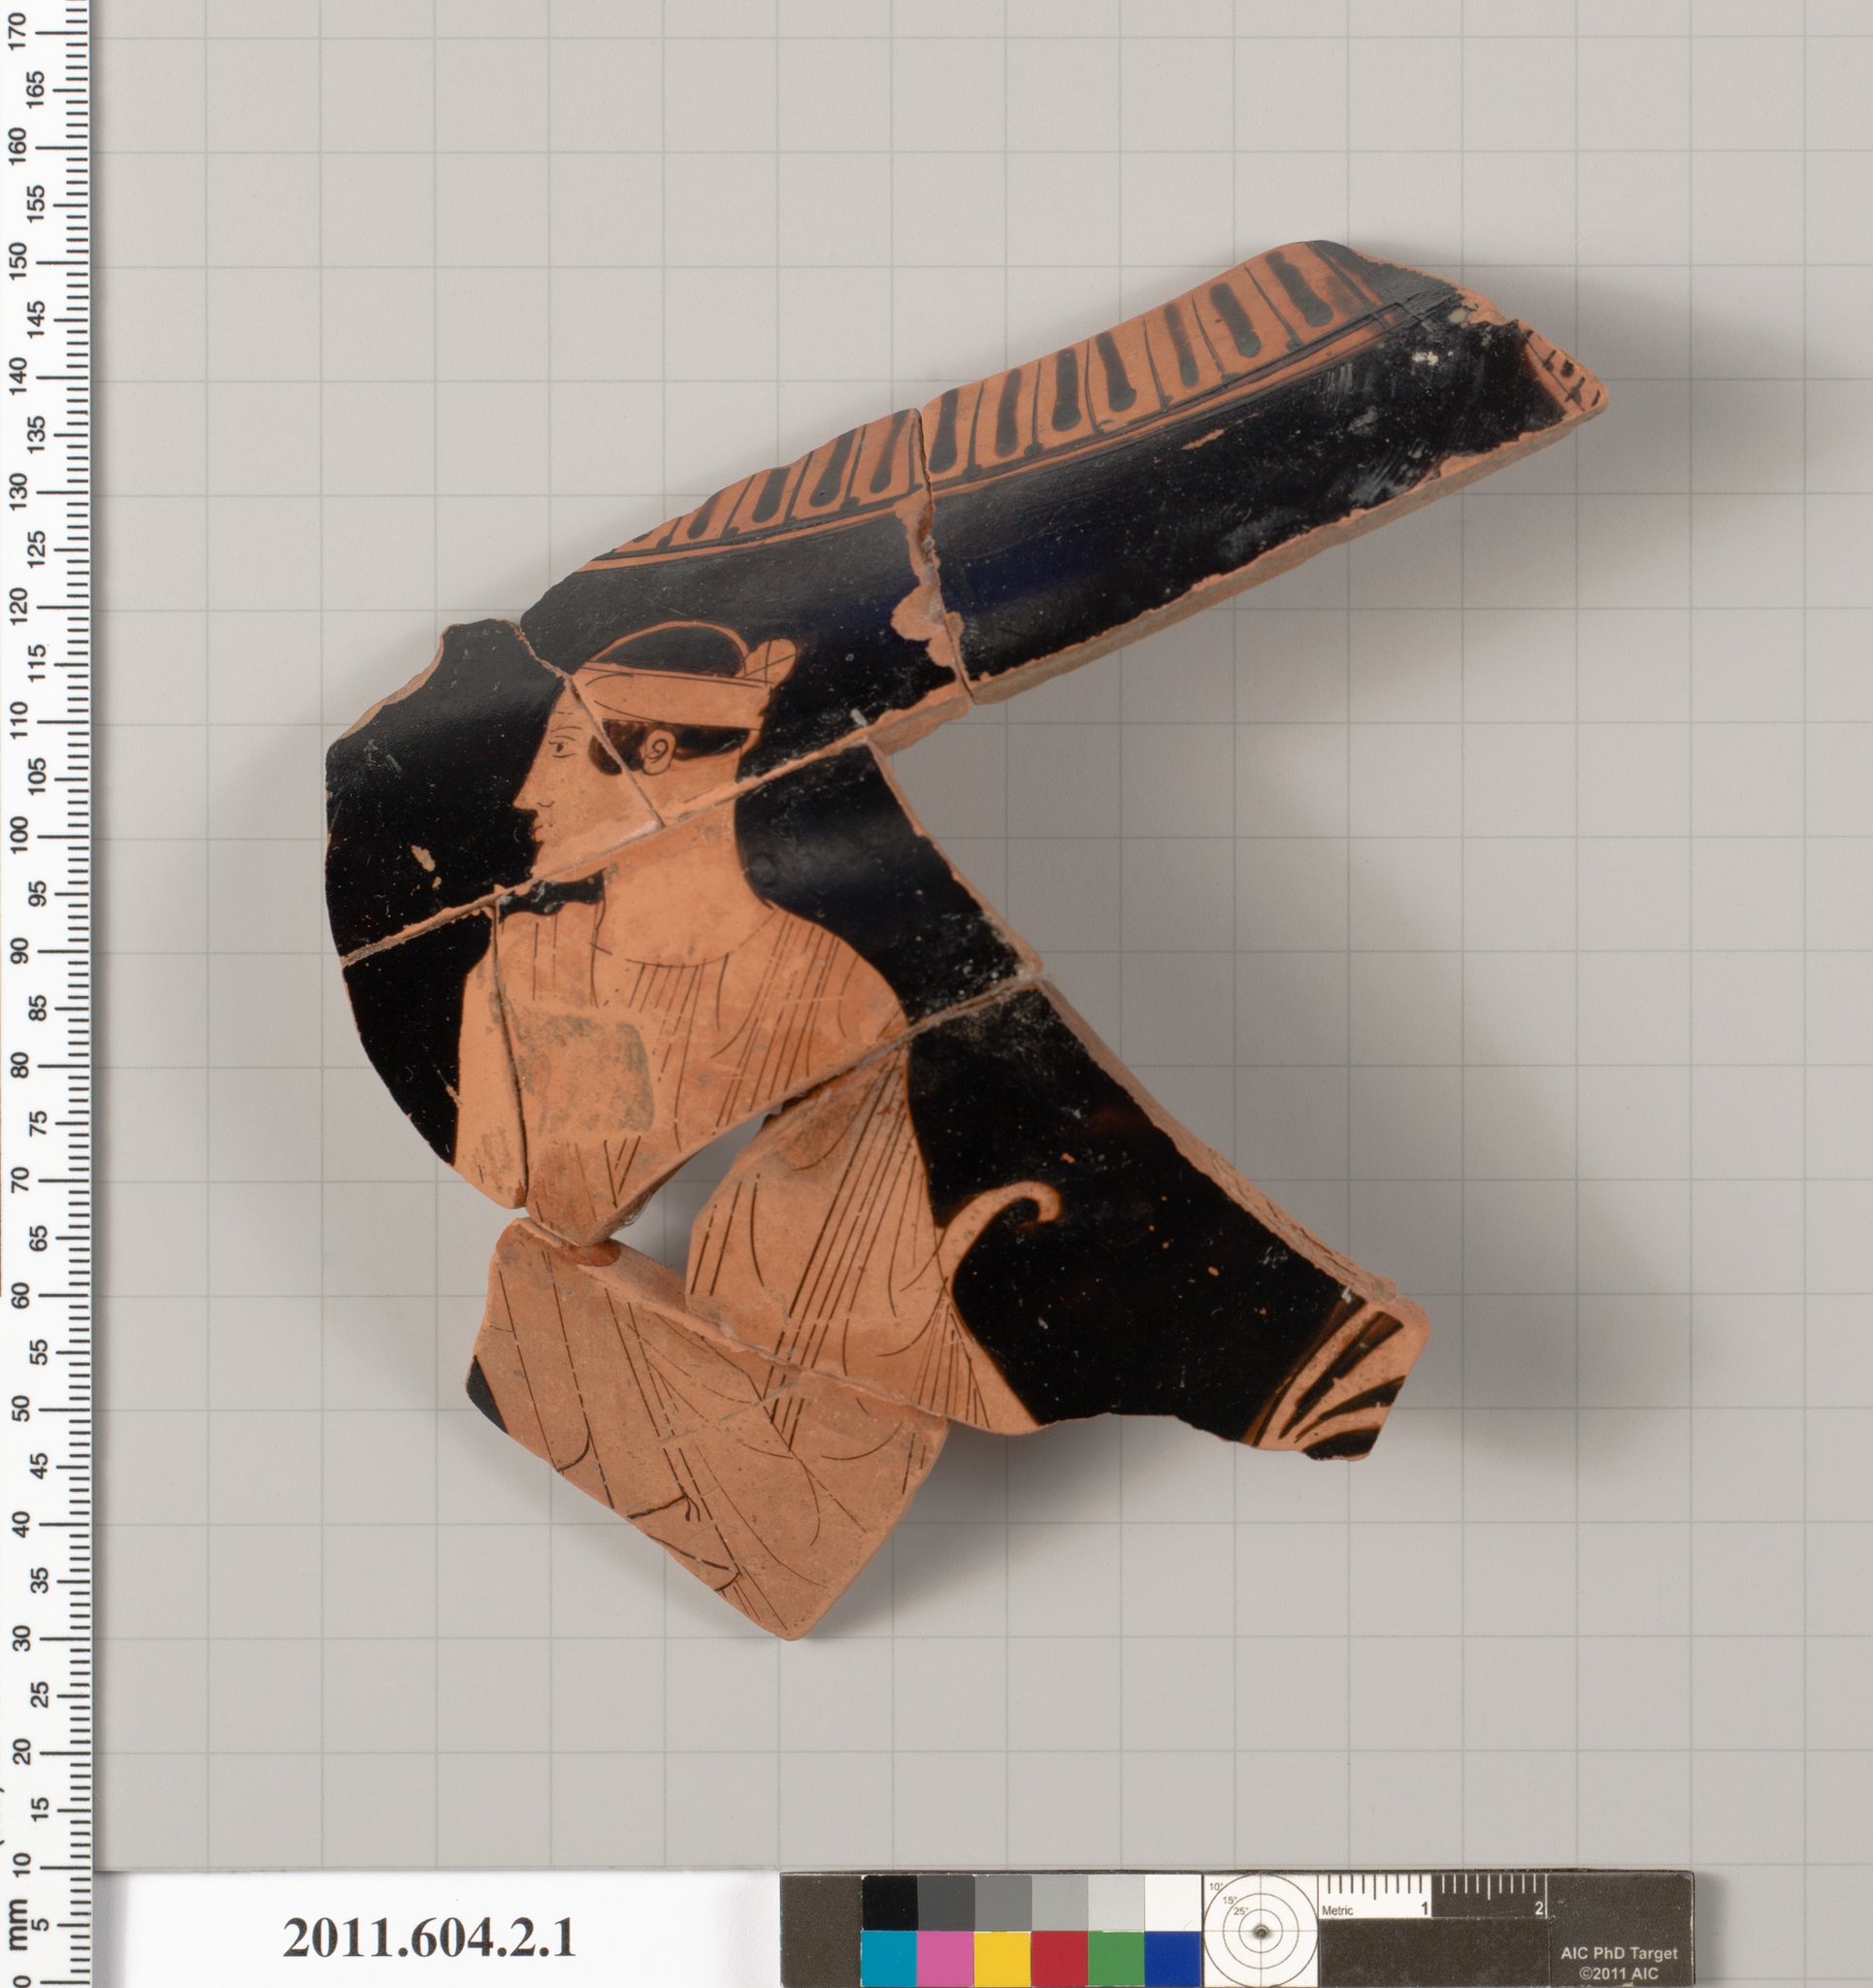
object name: neck amphora fragment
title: Terracotta fragment of a neck-amphora (jar)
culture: greek, attic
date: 460-450 BCE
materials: terracotta